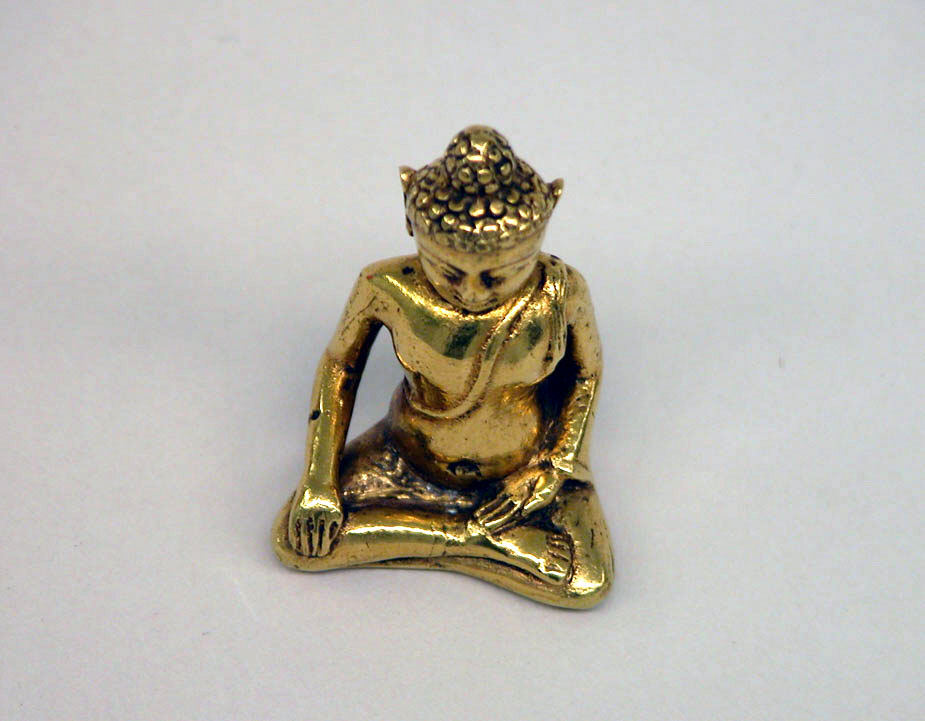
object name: figurine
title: Sculpture of the Buddha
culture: indonesian, javanese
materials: gold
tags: buddhism,buddha